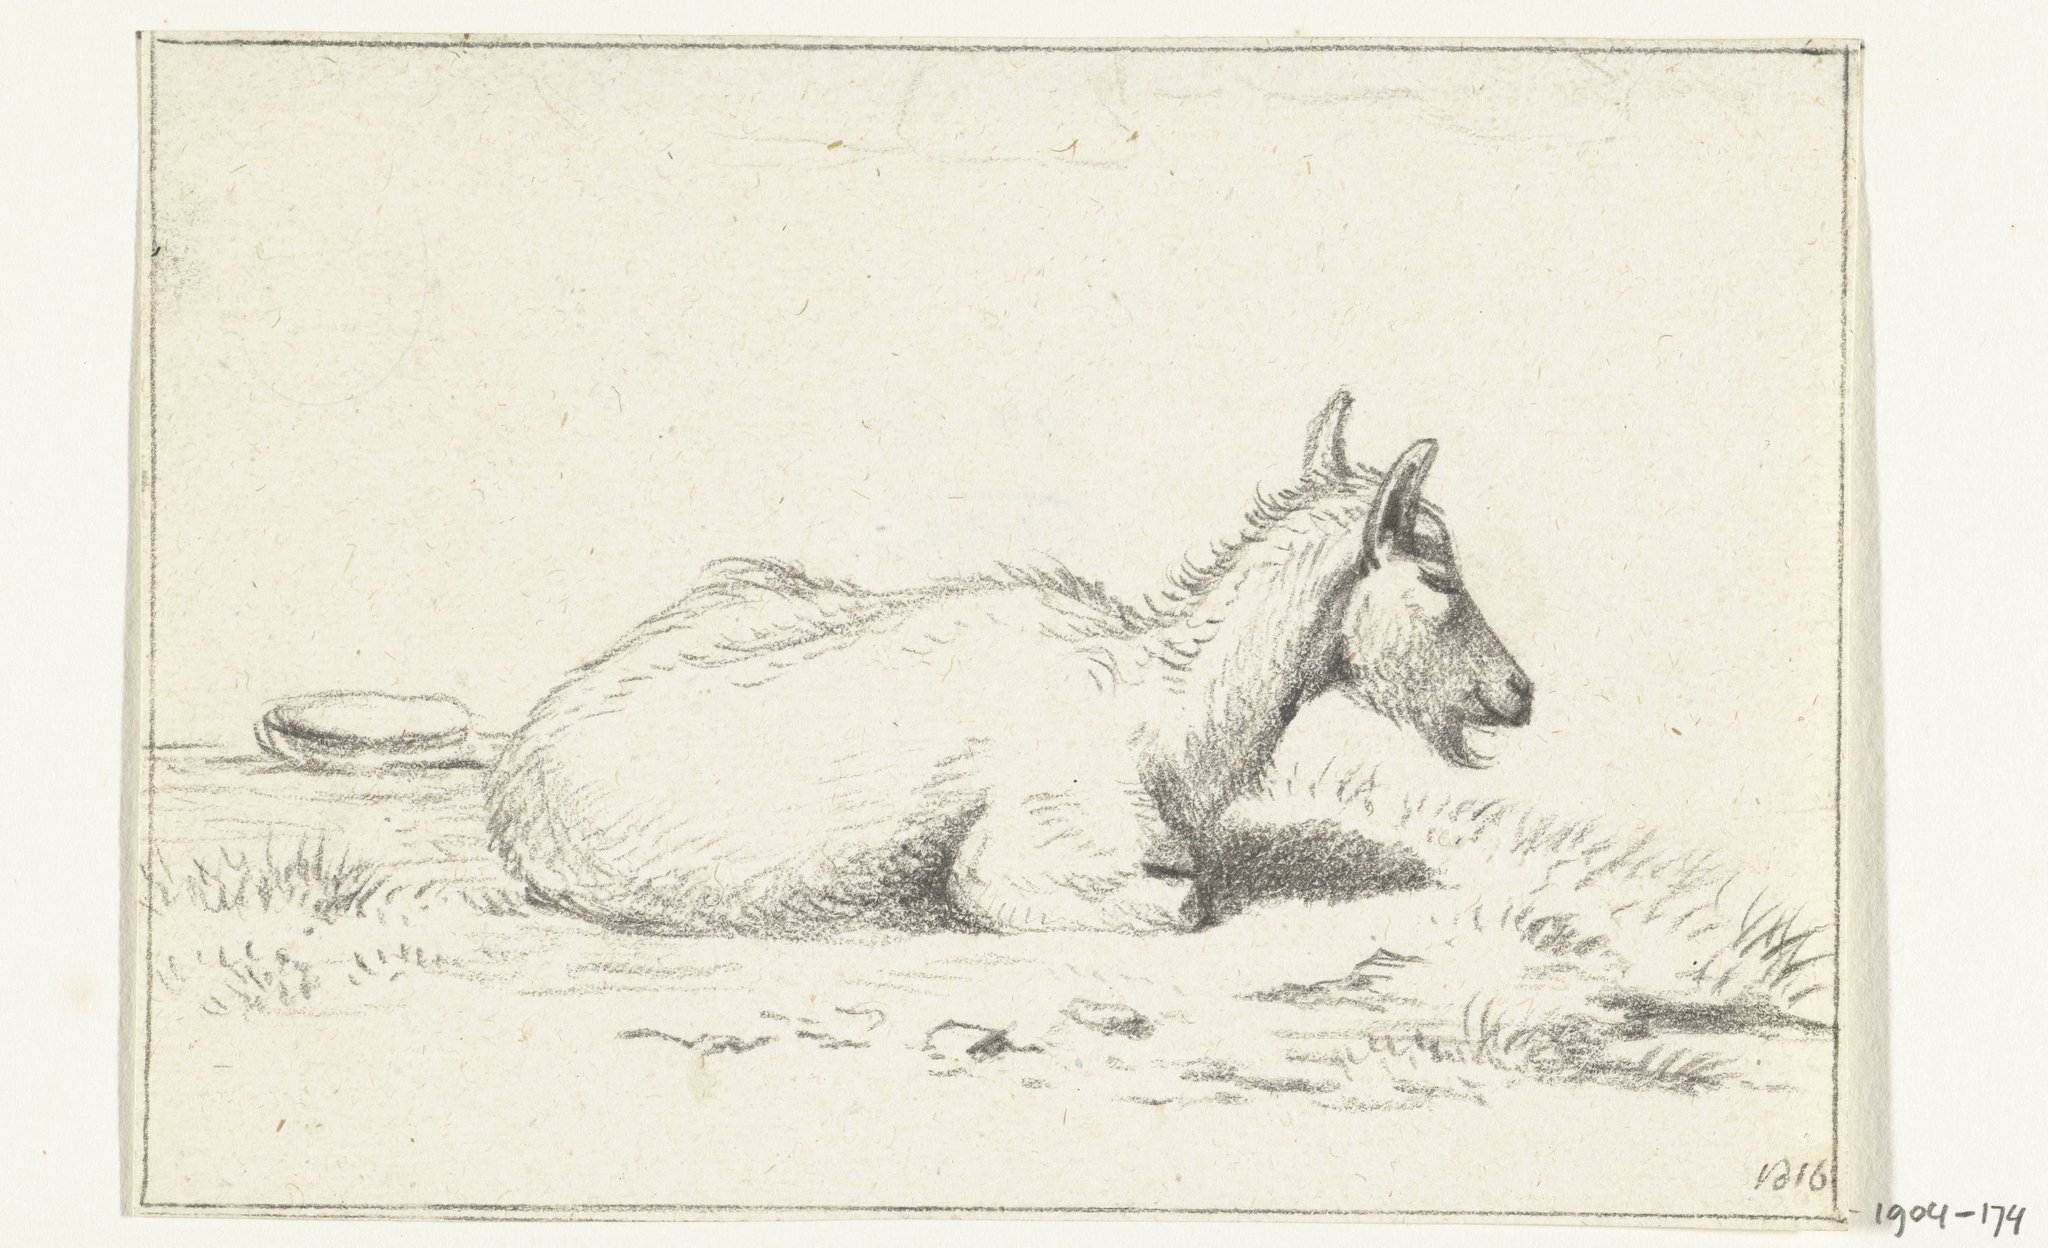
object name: drawing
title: Liggende geit, naar rechts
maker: jean bernard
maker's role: draughtsman, print maker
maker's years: 1765-1833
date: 1816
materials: chalk, paper, pencil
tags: goat